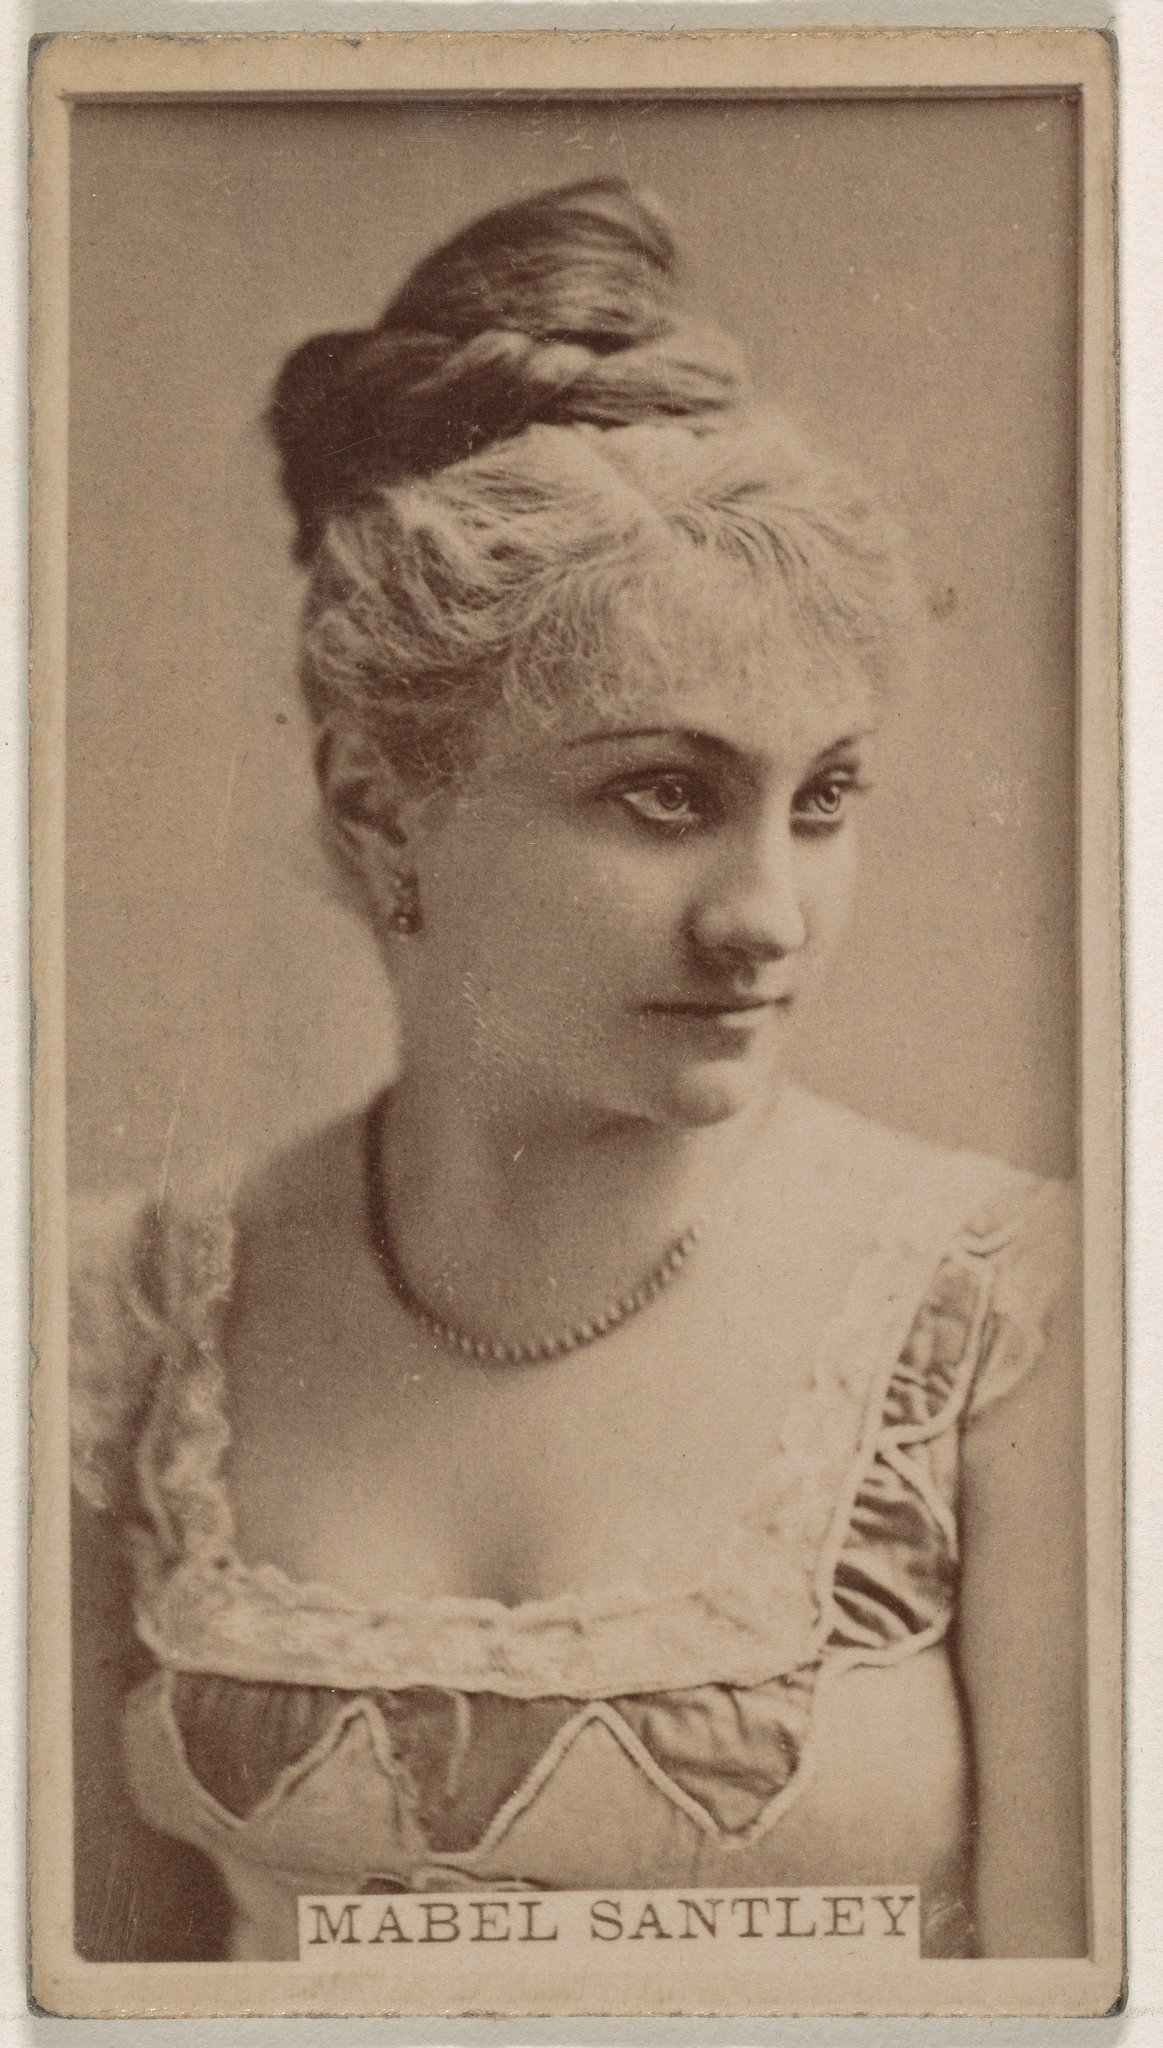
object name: photograph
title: Mabel Santley, from the Actresses series (N245) issued by Kinney Brothers to promote Sweet Caporal Cigarettes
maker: kinney brothers tobacco company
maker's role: publisher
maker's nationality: american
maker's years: 1869-2011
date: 1890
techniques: albumen silver print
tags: portraits,women,actresses